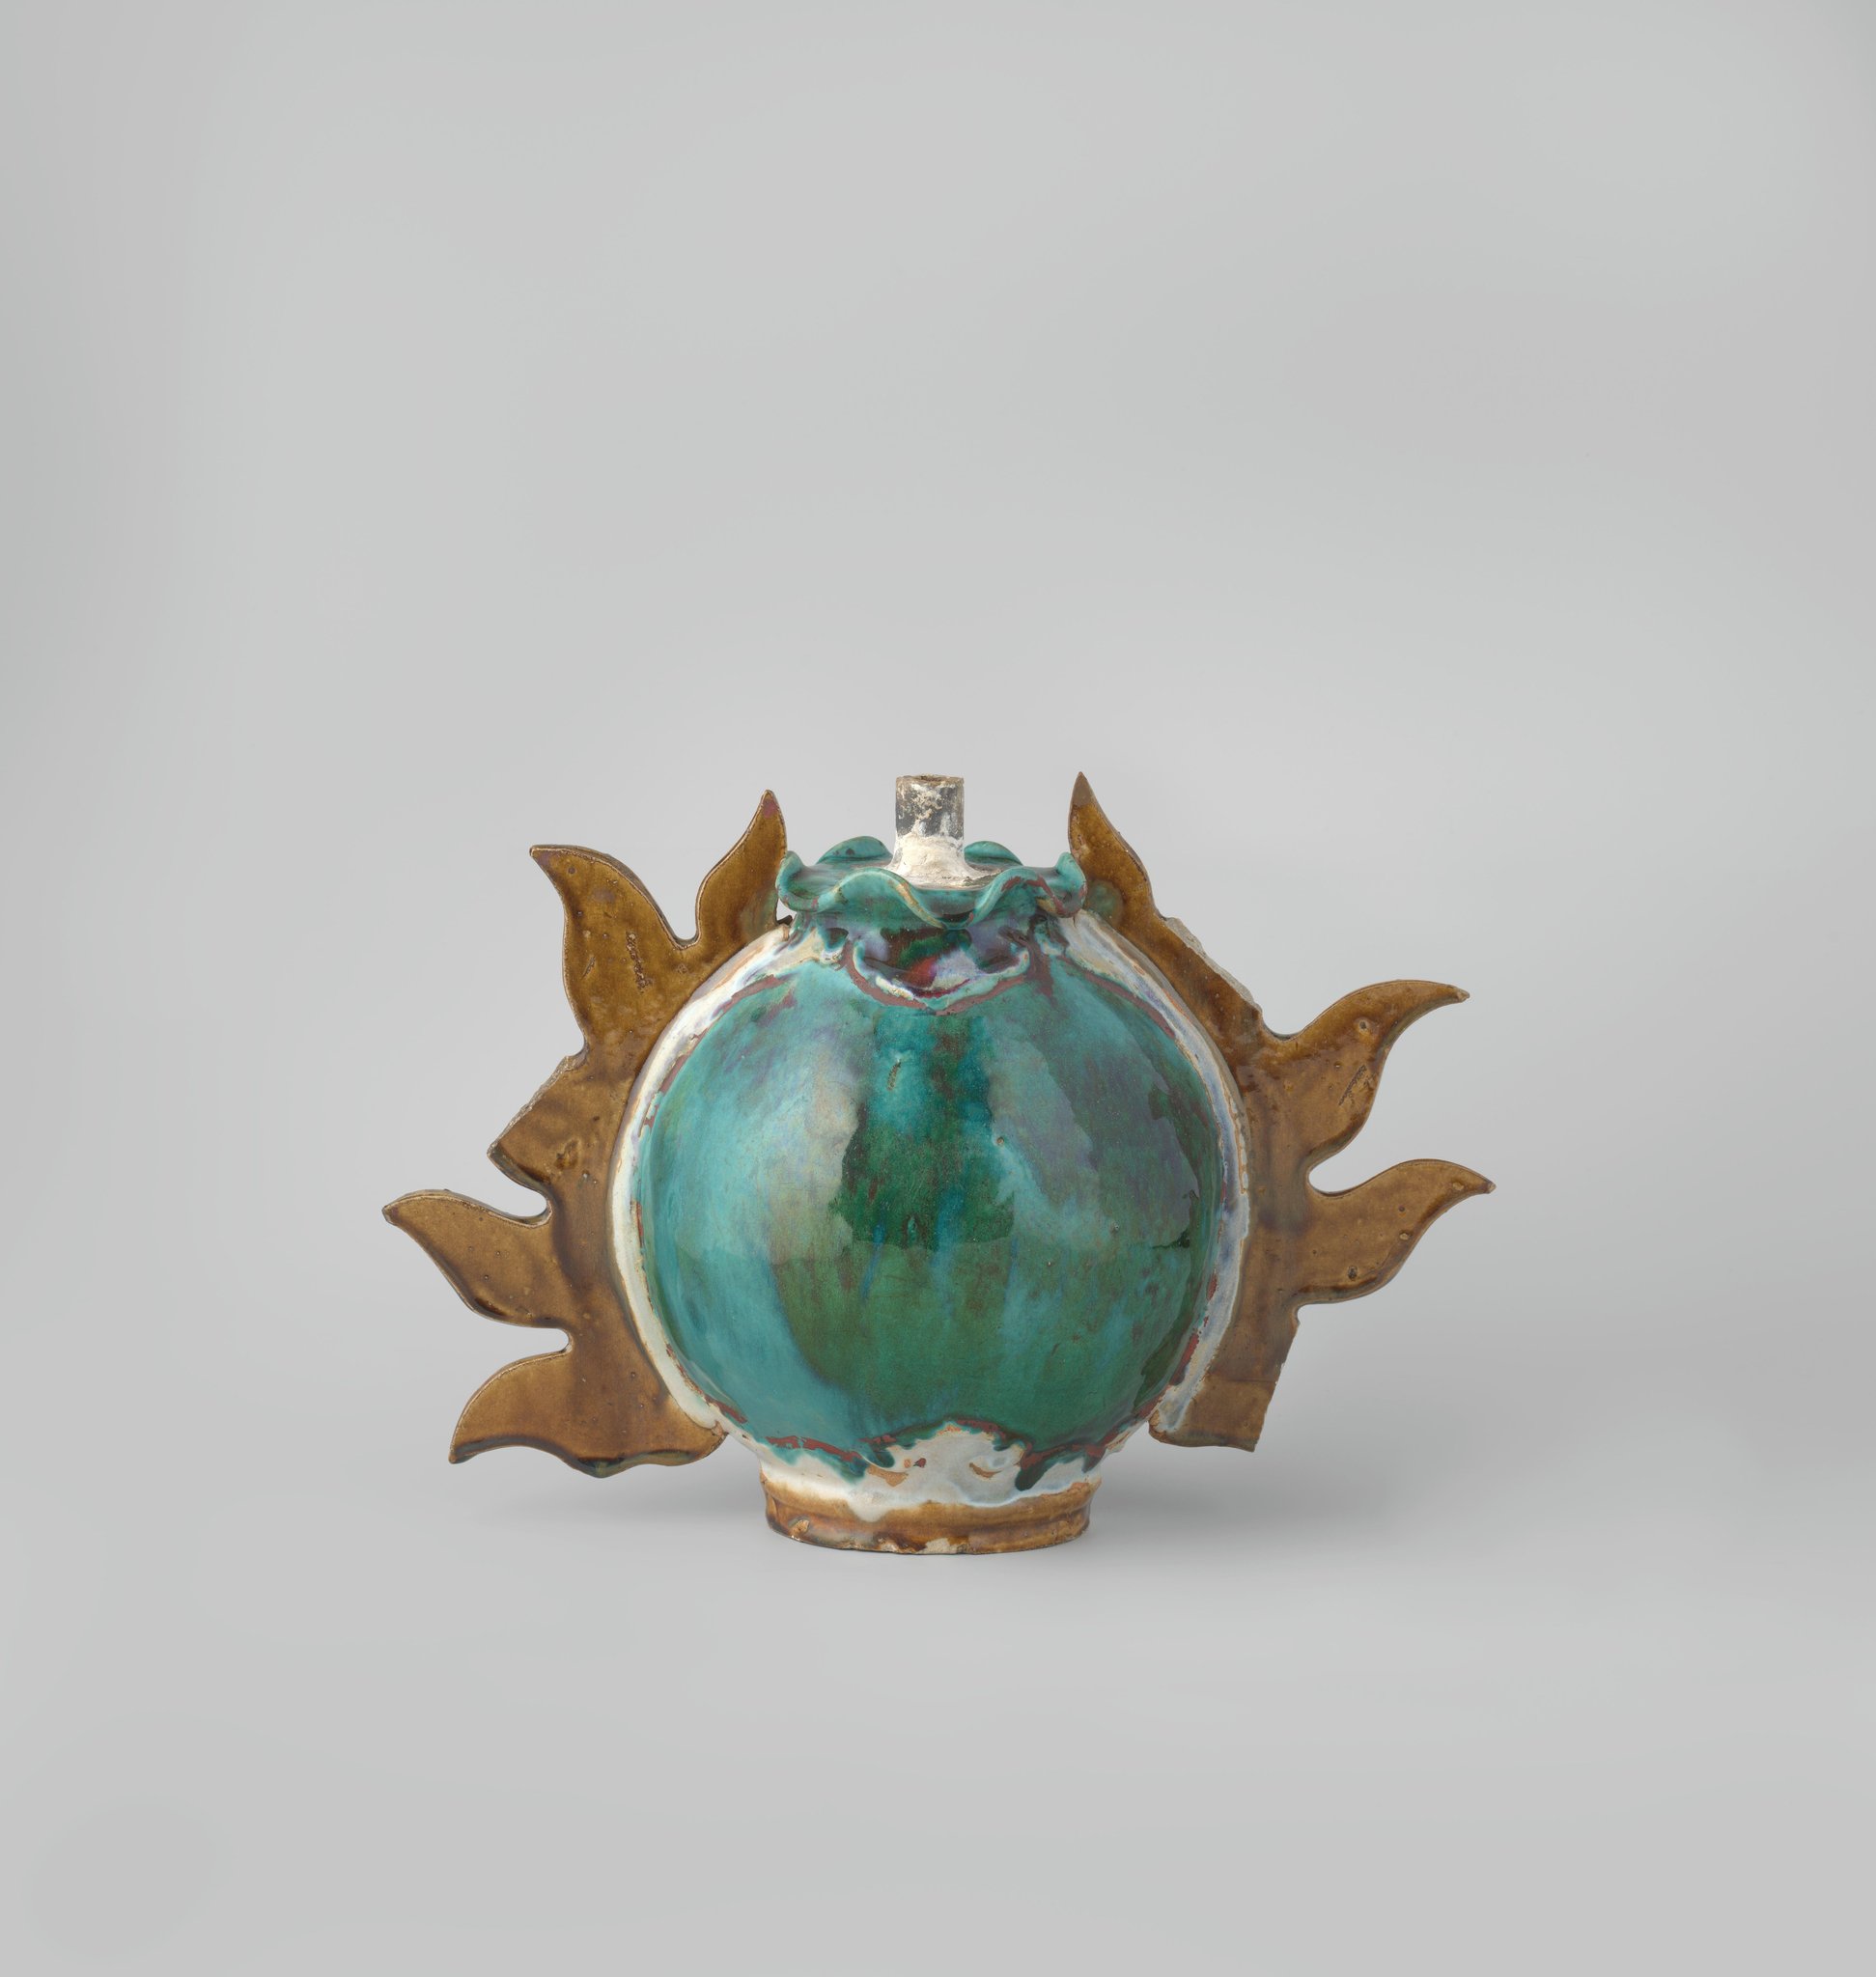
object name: sculpture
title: Ornament, onderdeel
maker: Anonymous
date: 1800-1850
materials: glaze, stoneware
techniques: vitrification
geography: guangdong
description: Tussendeel van ornament, voorstellende een groene zon met stralende vlammen. Steengoed met verschillende kleuren glazuur.